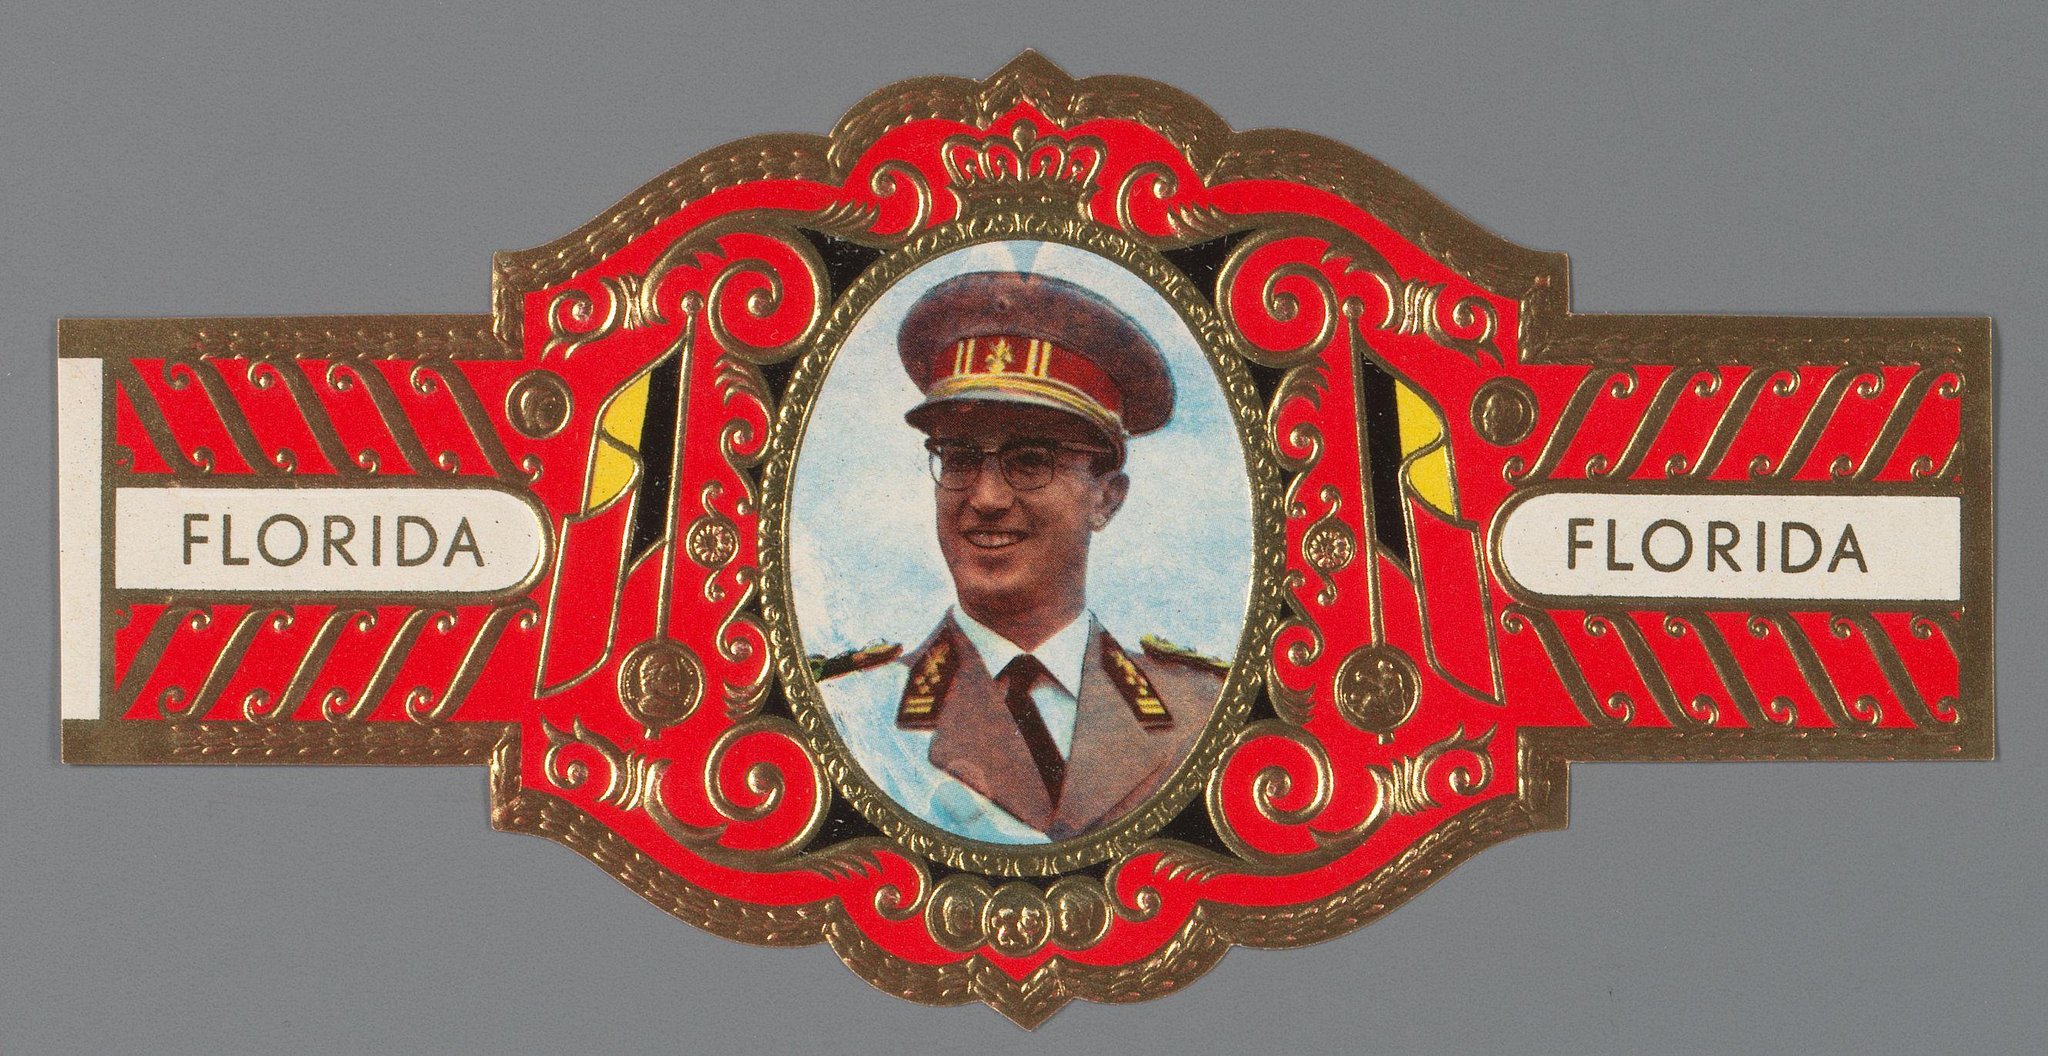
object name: photomechanical print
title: Portret van koning Boudewijn van België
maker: Anonymous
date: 1955-1970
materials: paper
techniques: blind stamped, printing block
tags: brussels, historical persons, king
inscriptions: inscription: ‘Florida’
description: Aan weerszijden van het portret is tweemaal de vlag van het land afgebeeld.